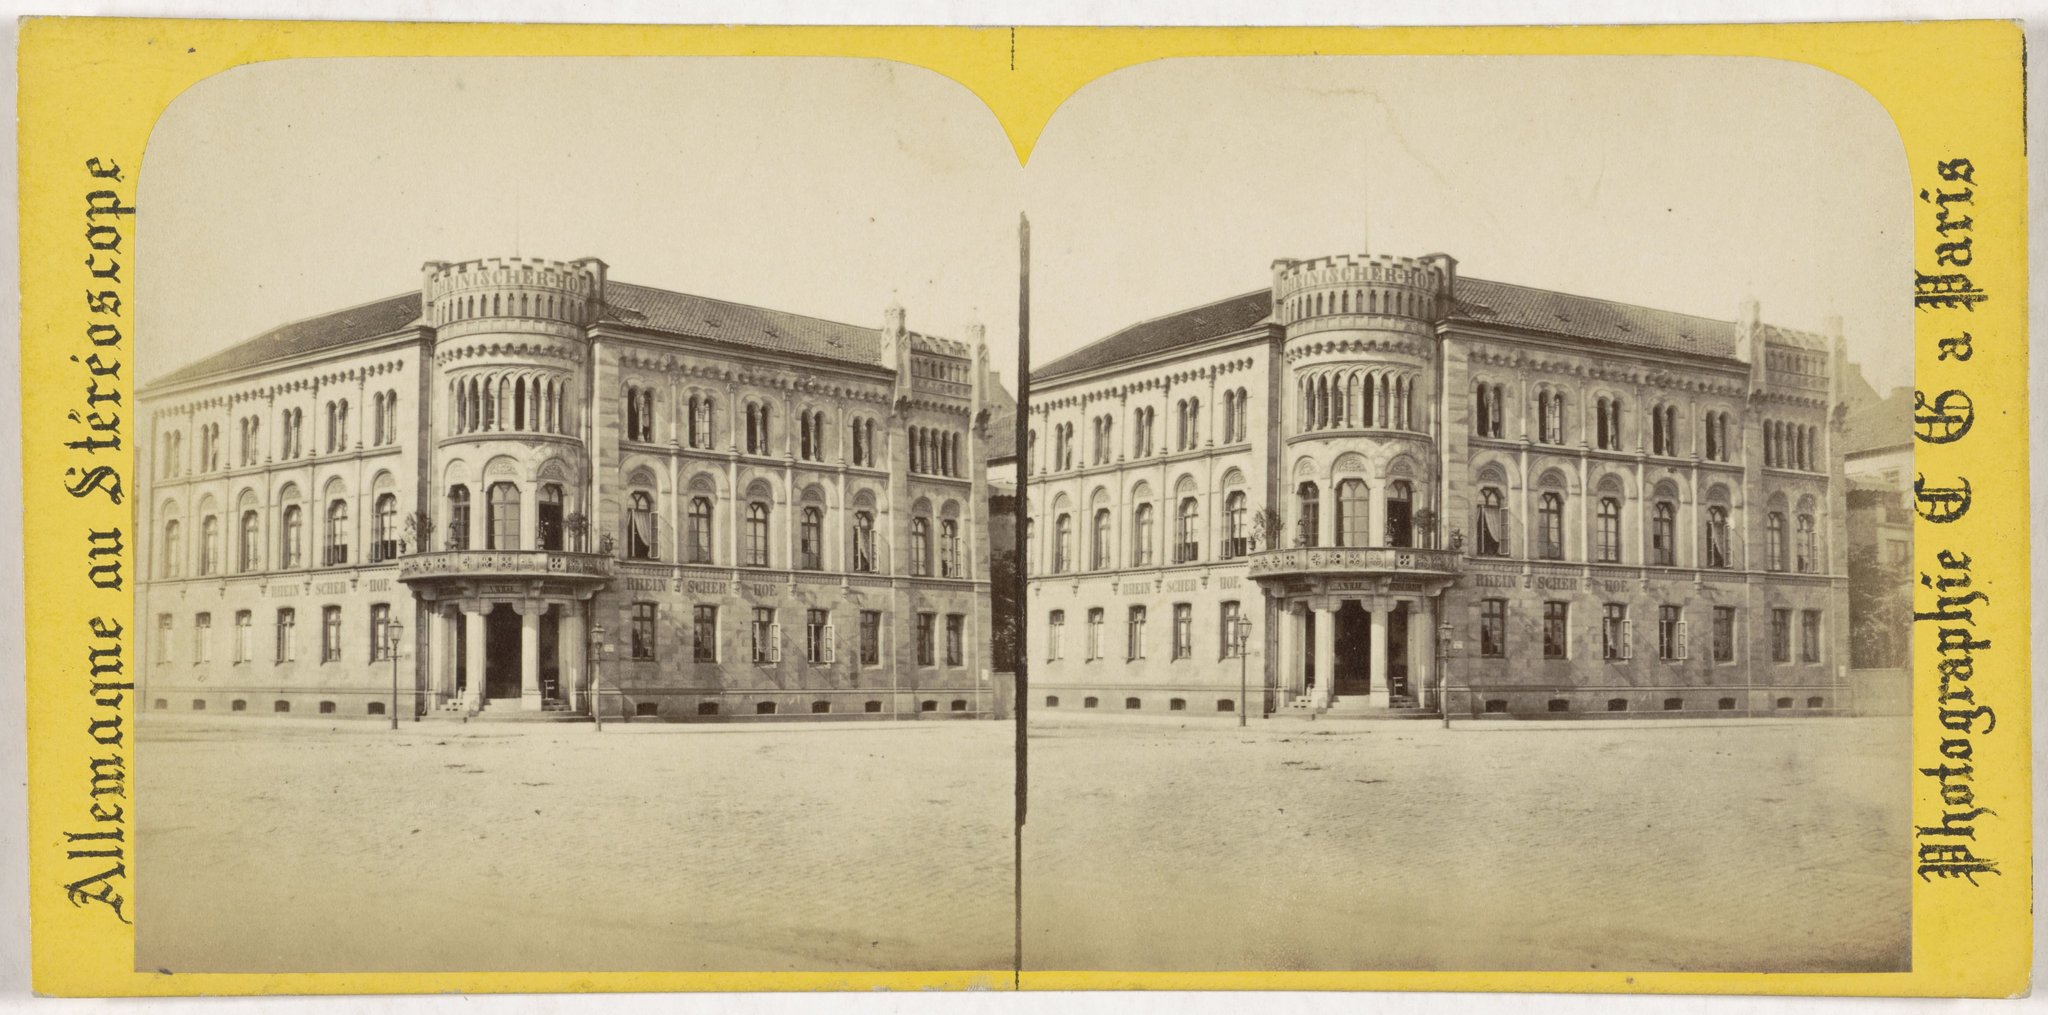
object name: stereograph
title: Allemagne au stéréoscope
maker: charles gaudin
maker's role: publisher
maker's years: 1825-1905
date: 1860-1870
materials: cardboard, paper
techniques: albumen print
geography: hannover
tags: exterior ~ representation of a building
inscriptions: number: ‘340’, number: ‘340.’